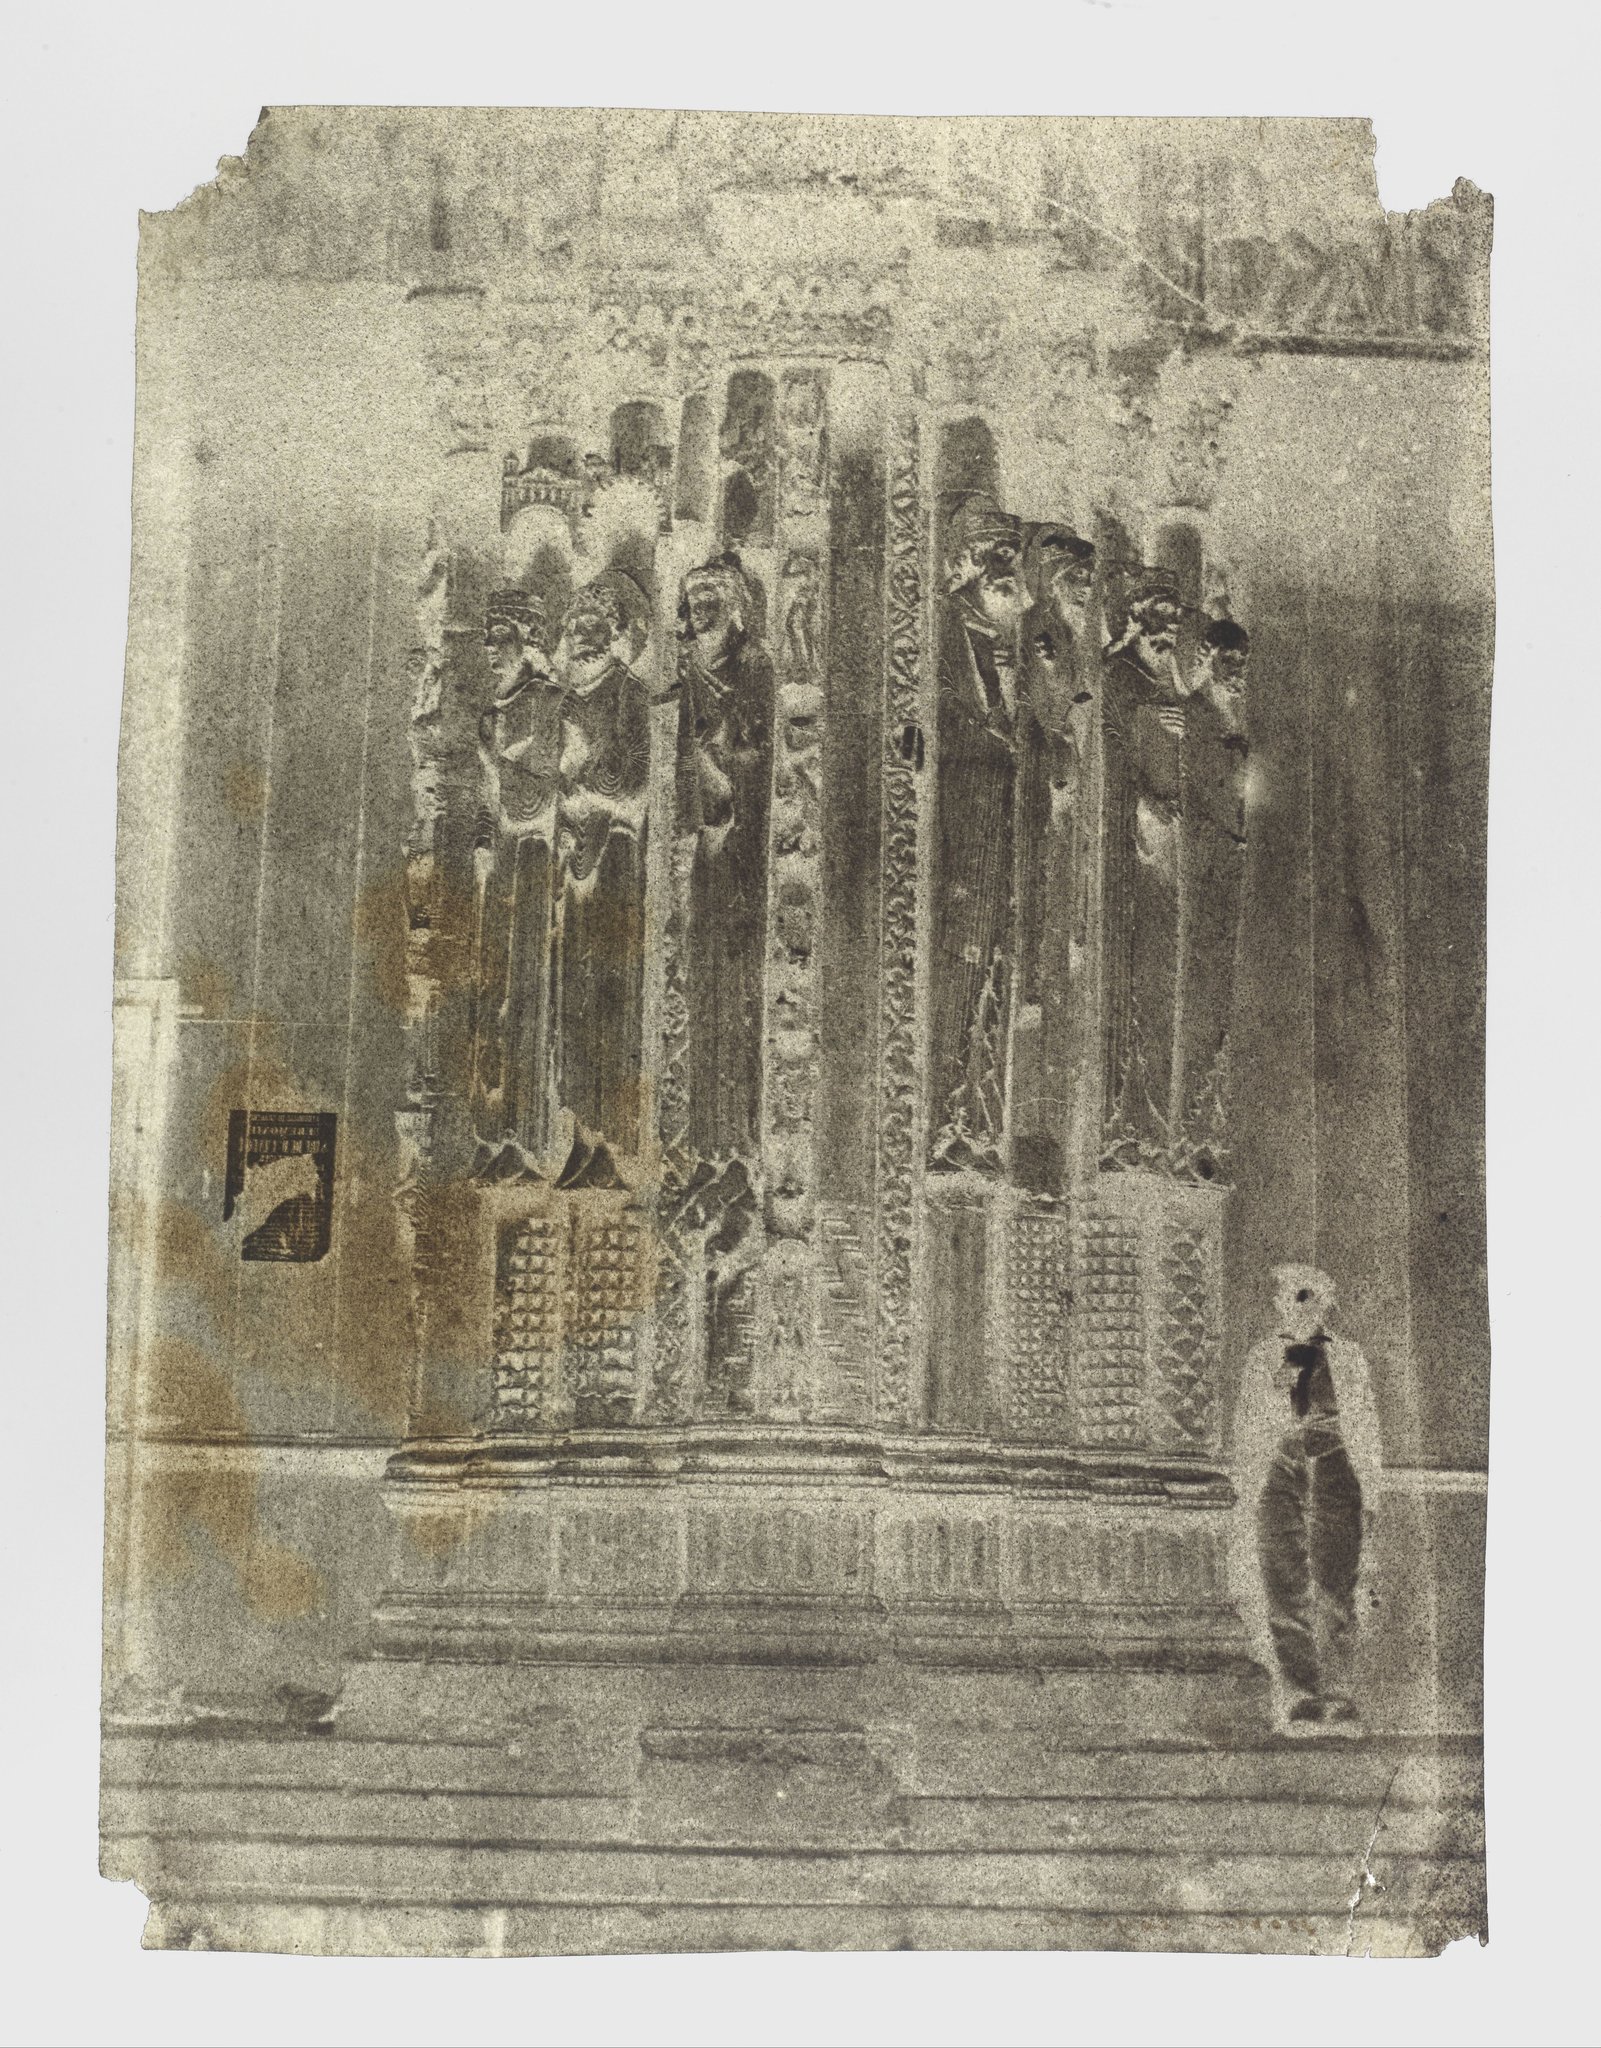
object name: papiernegatief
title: Porte royale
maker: charles nègre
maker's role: fotograaf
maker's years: 1820-1880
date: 1854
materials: paper, wax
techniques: paper negative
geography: chartres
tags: parts of church exterior and annexes: portal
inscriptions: inscription: ‘Porte Royale’